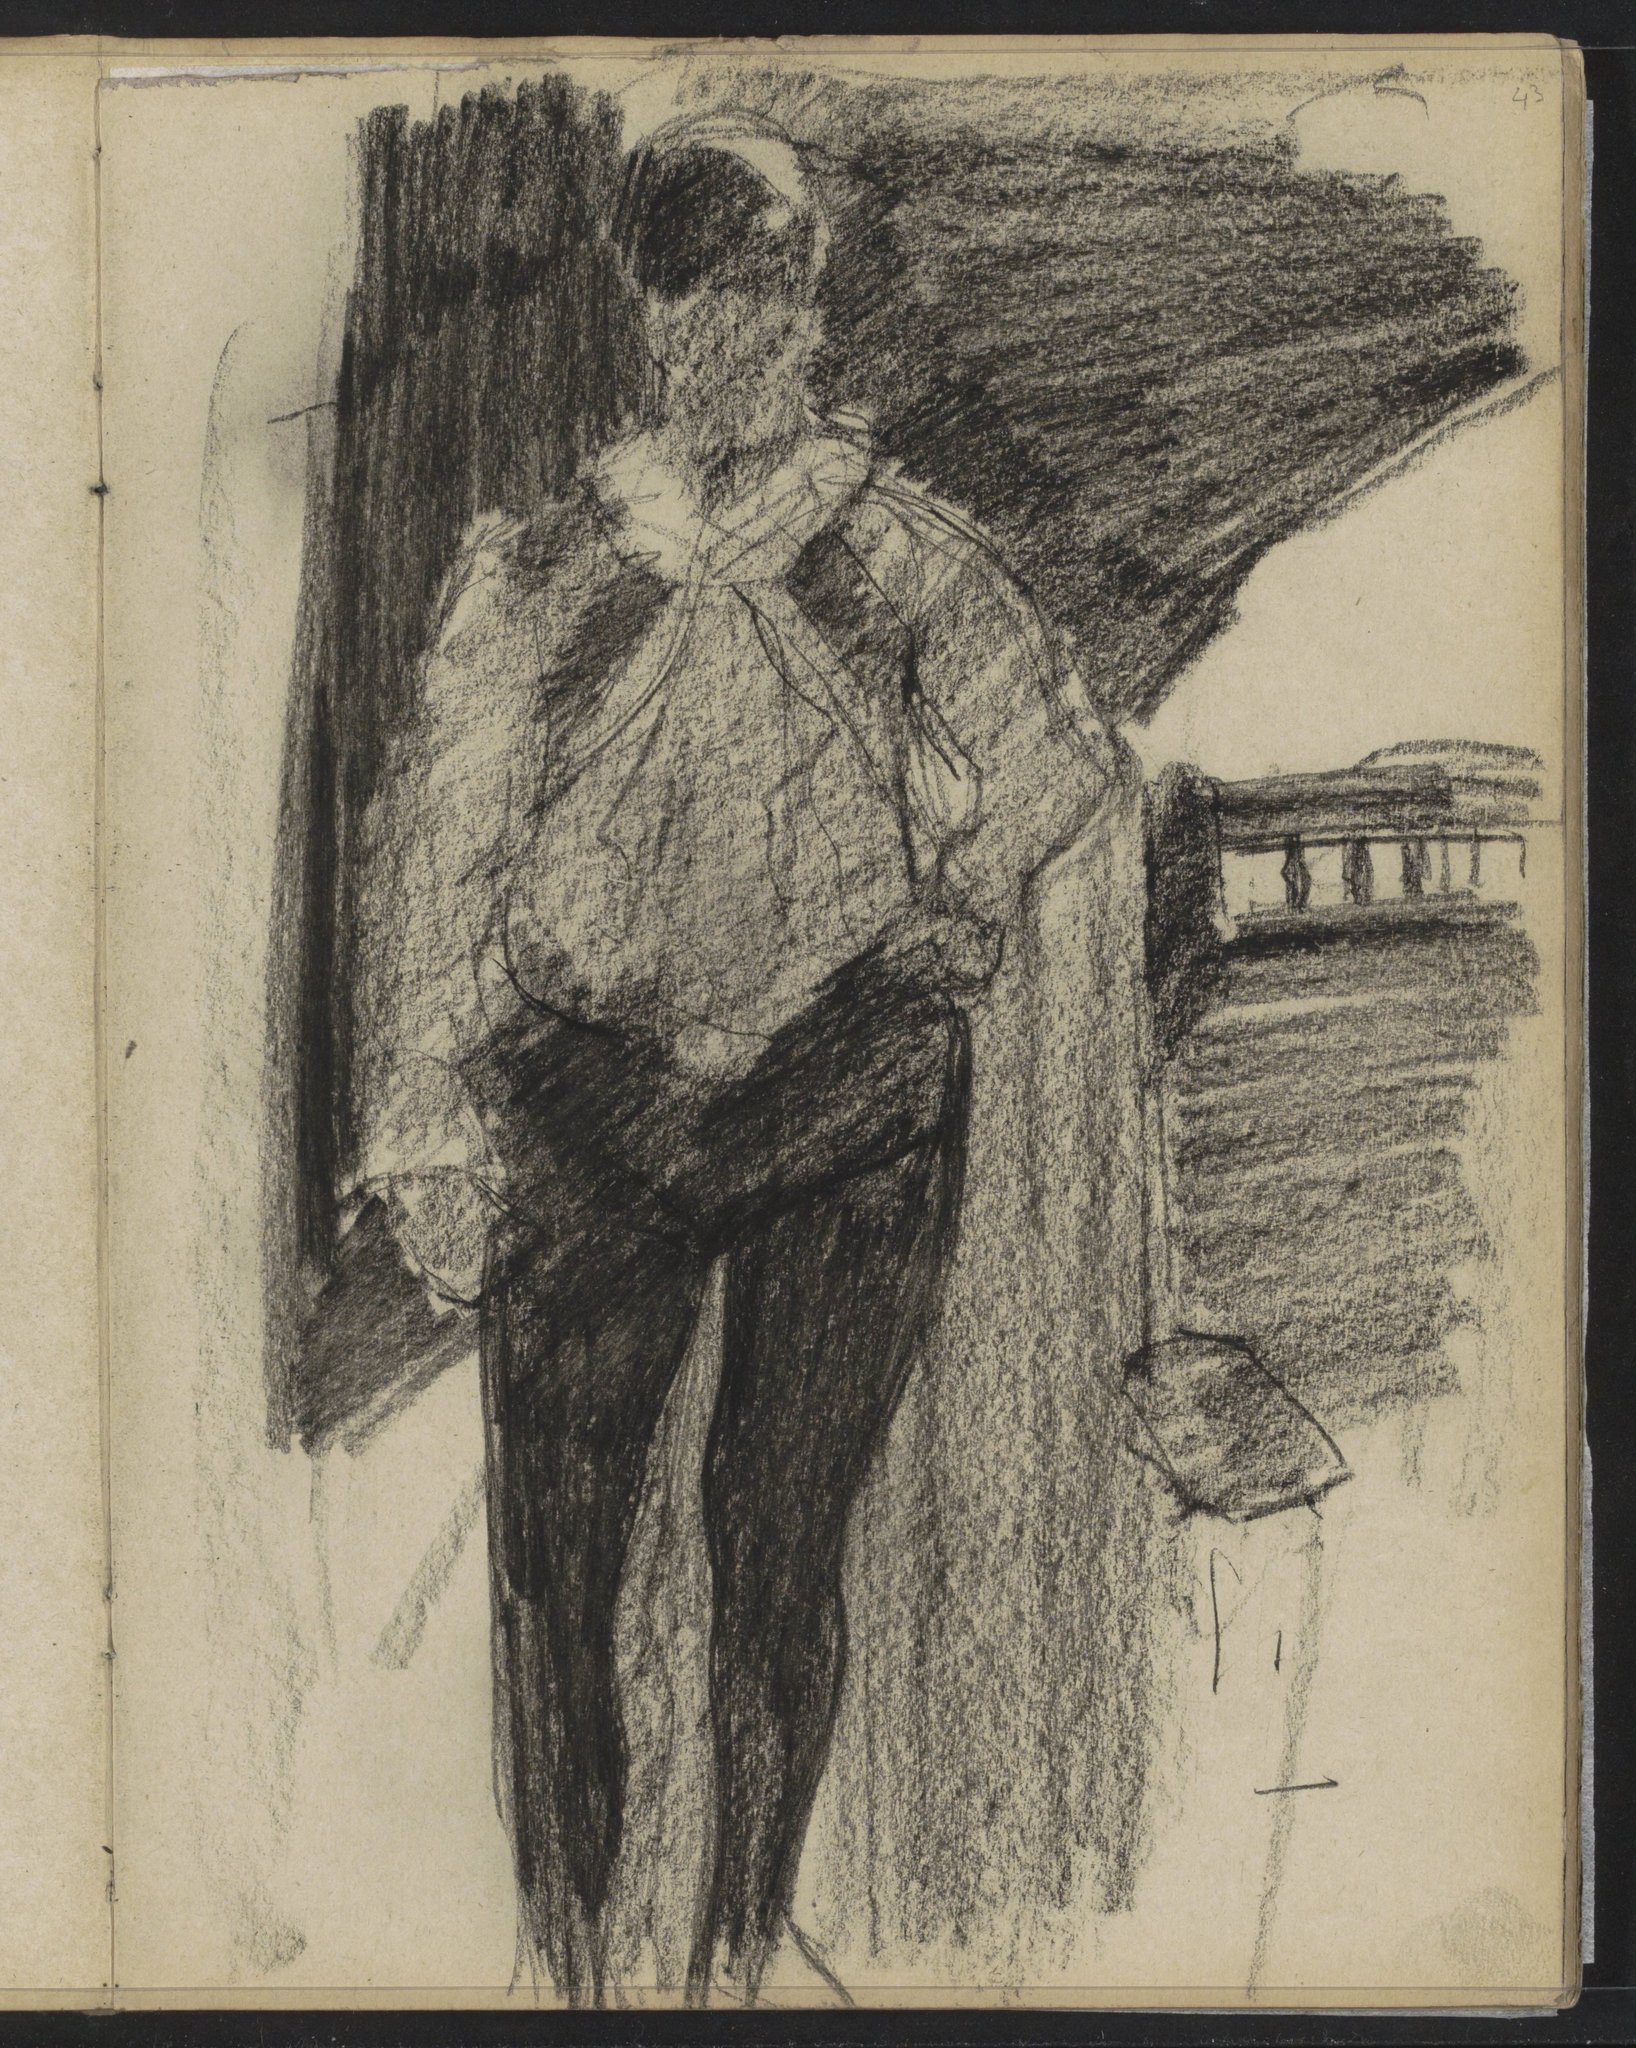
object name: sketchbook leaf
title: Staande figuur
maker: willem witsen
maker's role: draughtsman, painter, print maker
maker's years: 1860-1923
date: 1886-1891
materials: chalk, paper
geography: london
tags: standing figure, bridge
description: Mogelijk op Waterloo Bridge te Londen. Pagina 43 uit een schetsboek met 40 bladen.